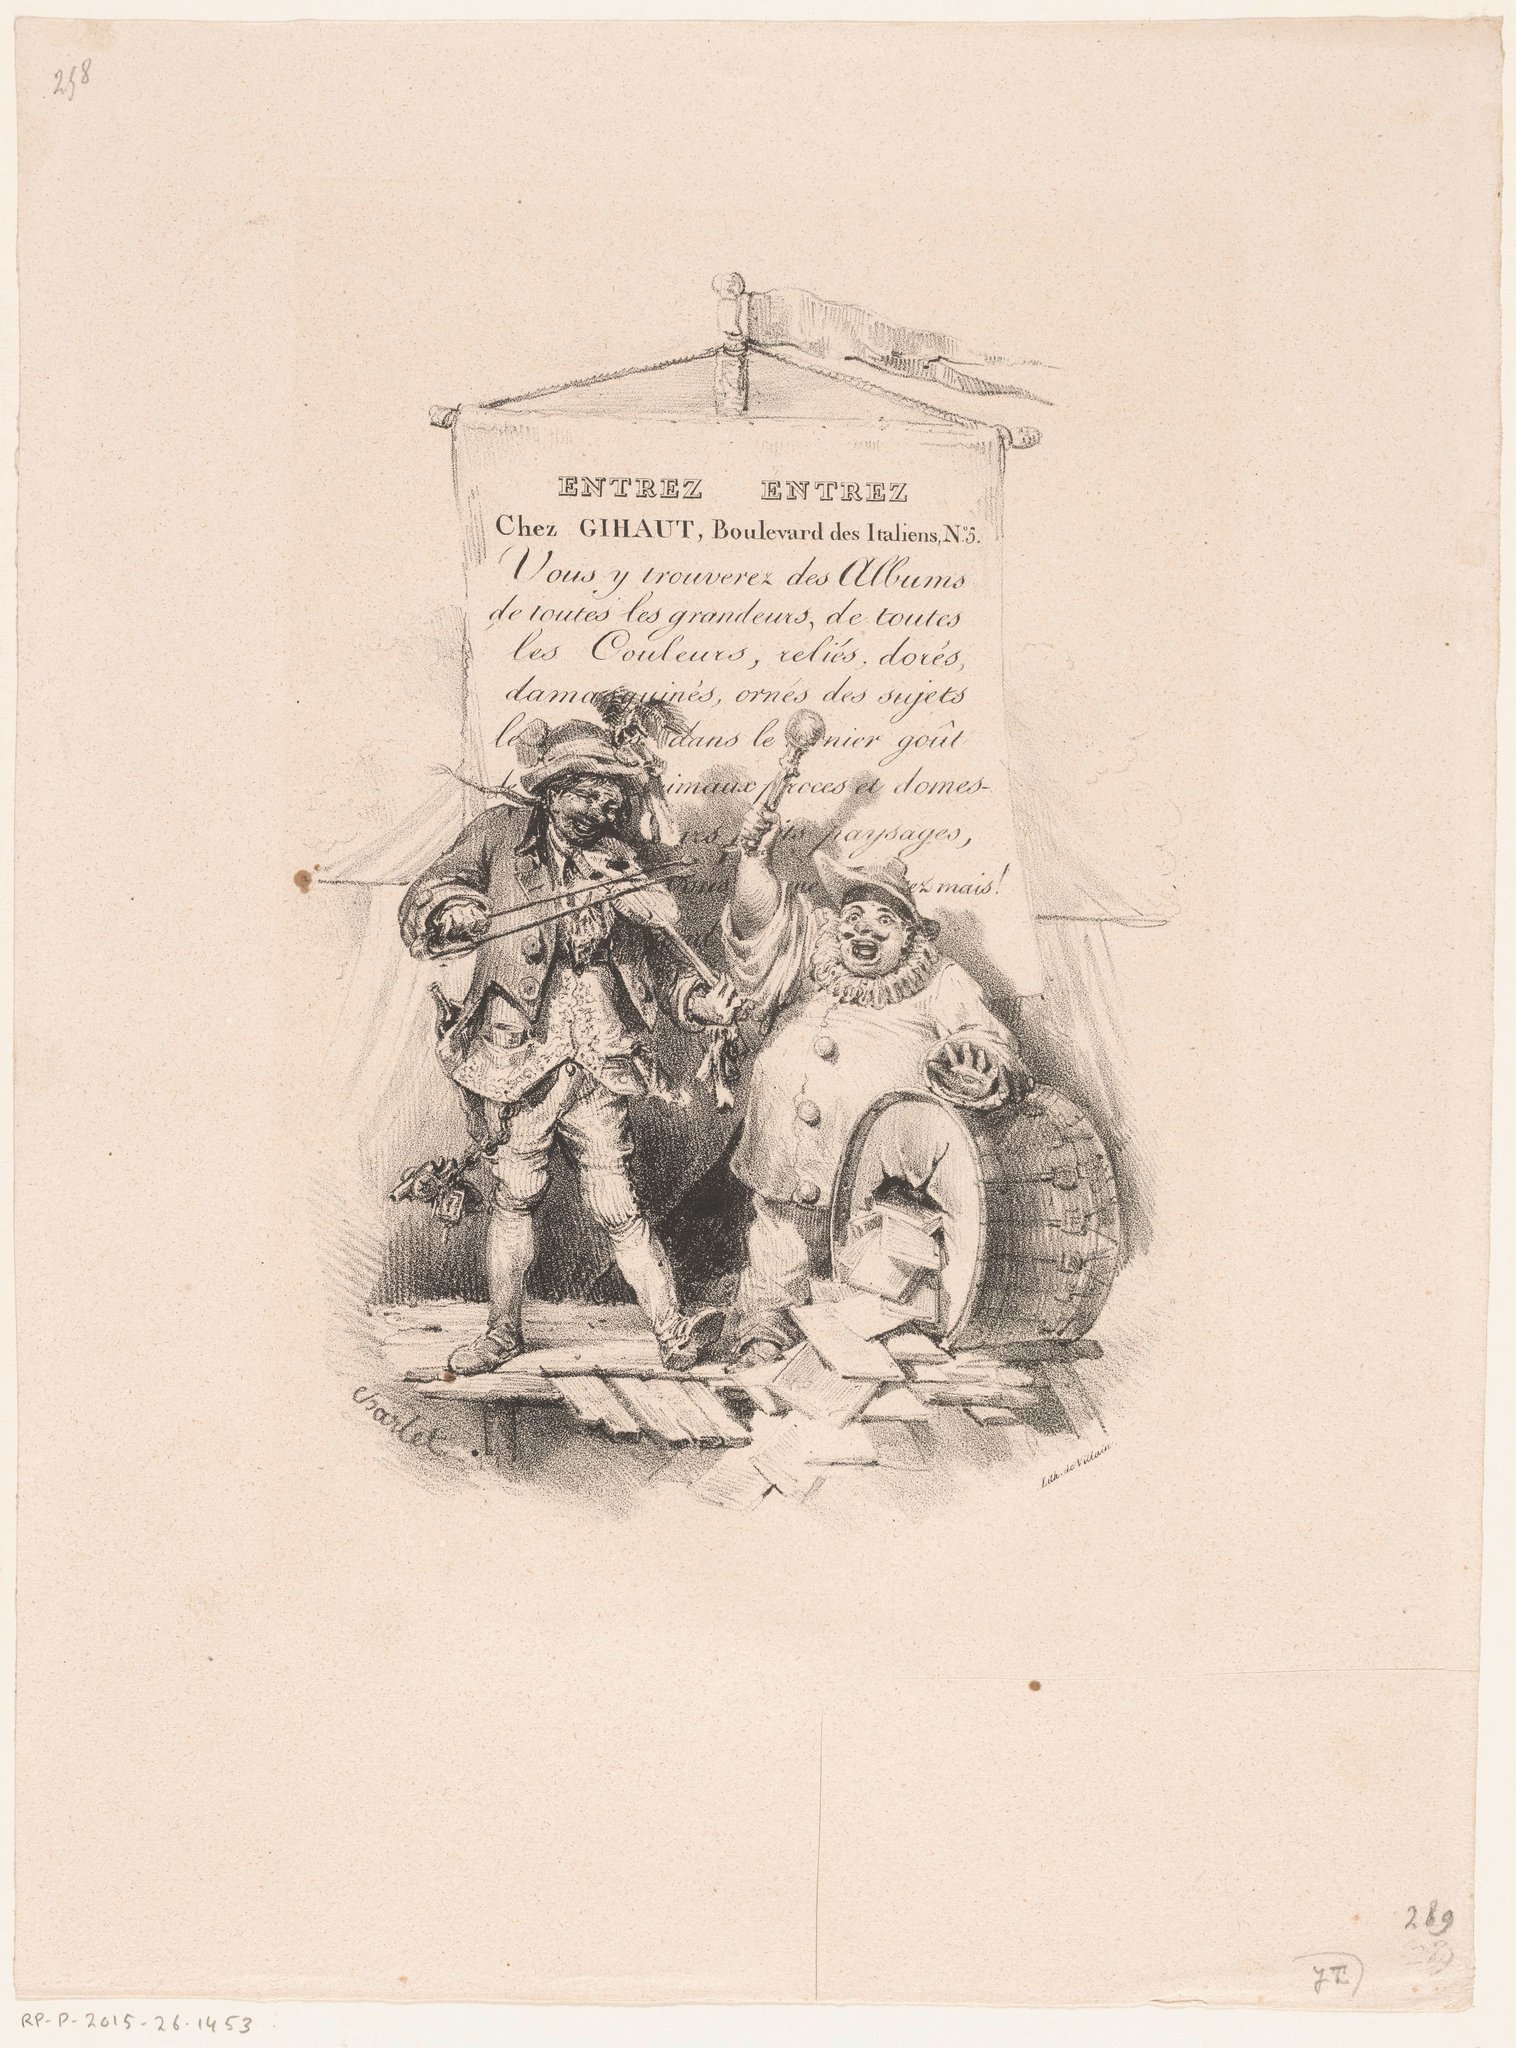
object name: print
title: Advertentie voor uitgever Gihaut te Parijs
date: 1820-1844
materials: paper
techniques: lithograph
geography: paris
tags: drum (musical instrument), violin, fiddle - cc - out of doors, advertisement, notice, clown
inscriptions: collector's mark: Lugt 4779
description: Een violist en een clown staan voor de ingang van een circustent. Boven hen hangt een spandoek met een wervende tekst voor uitgever Gihaut. De clown slaat op een trom met een gat waaruit boeken vallen.